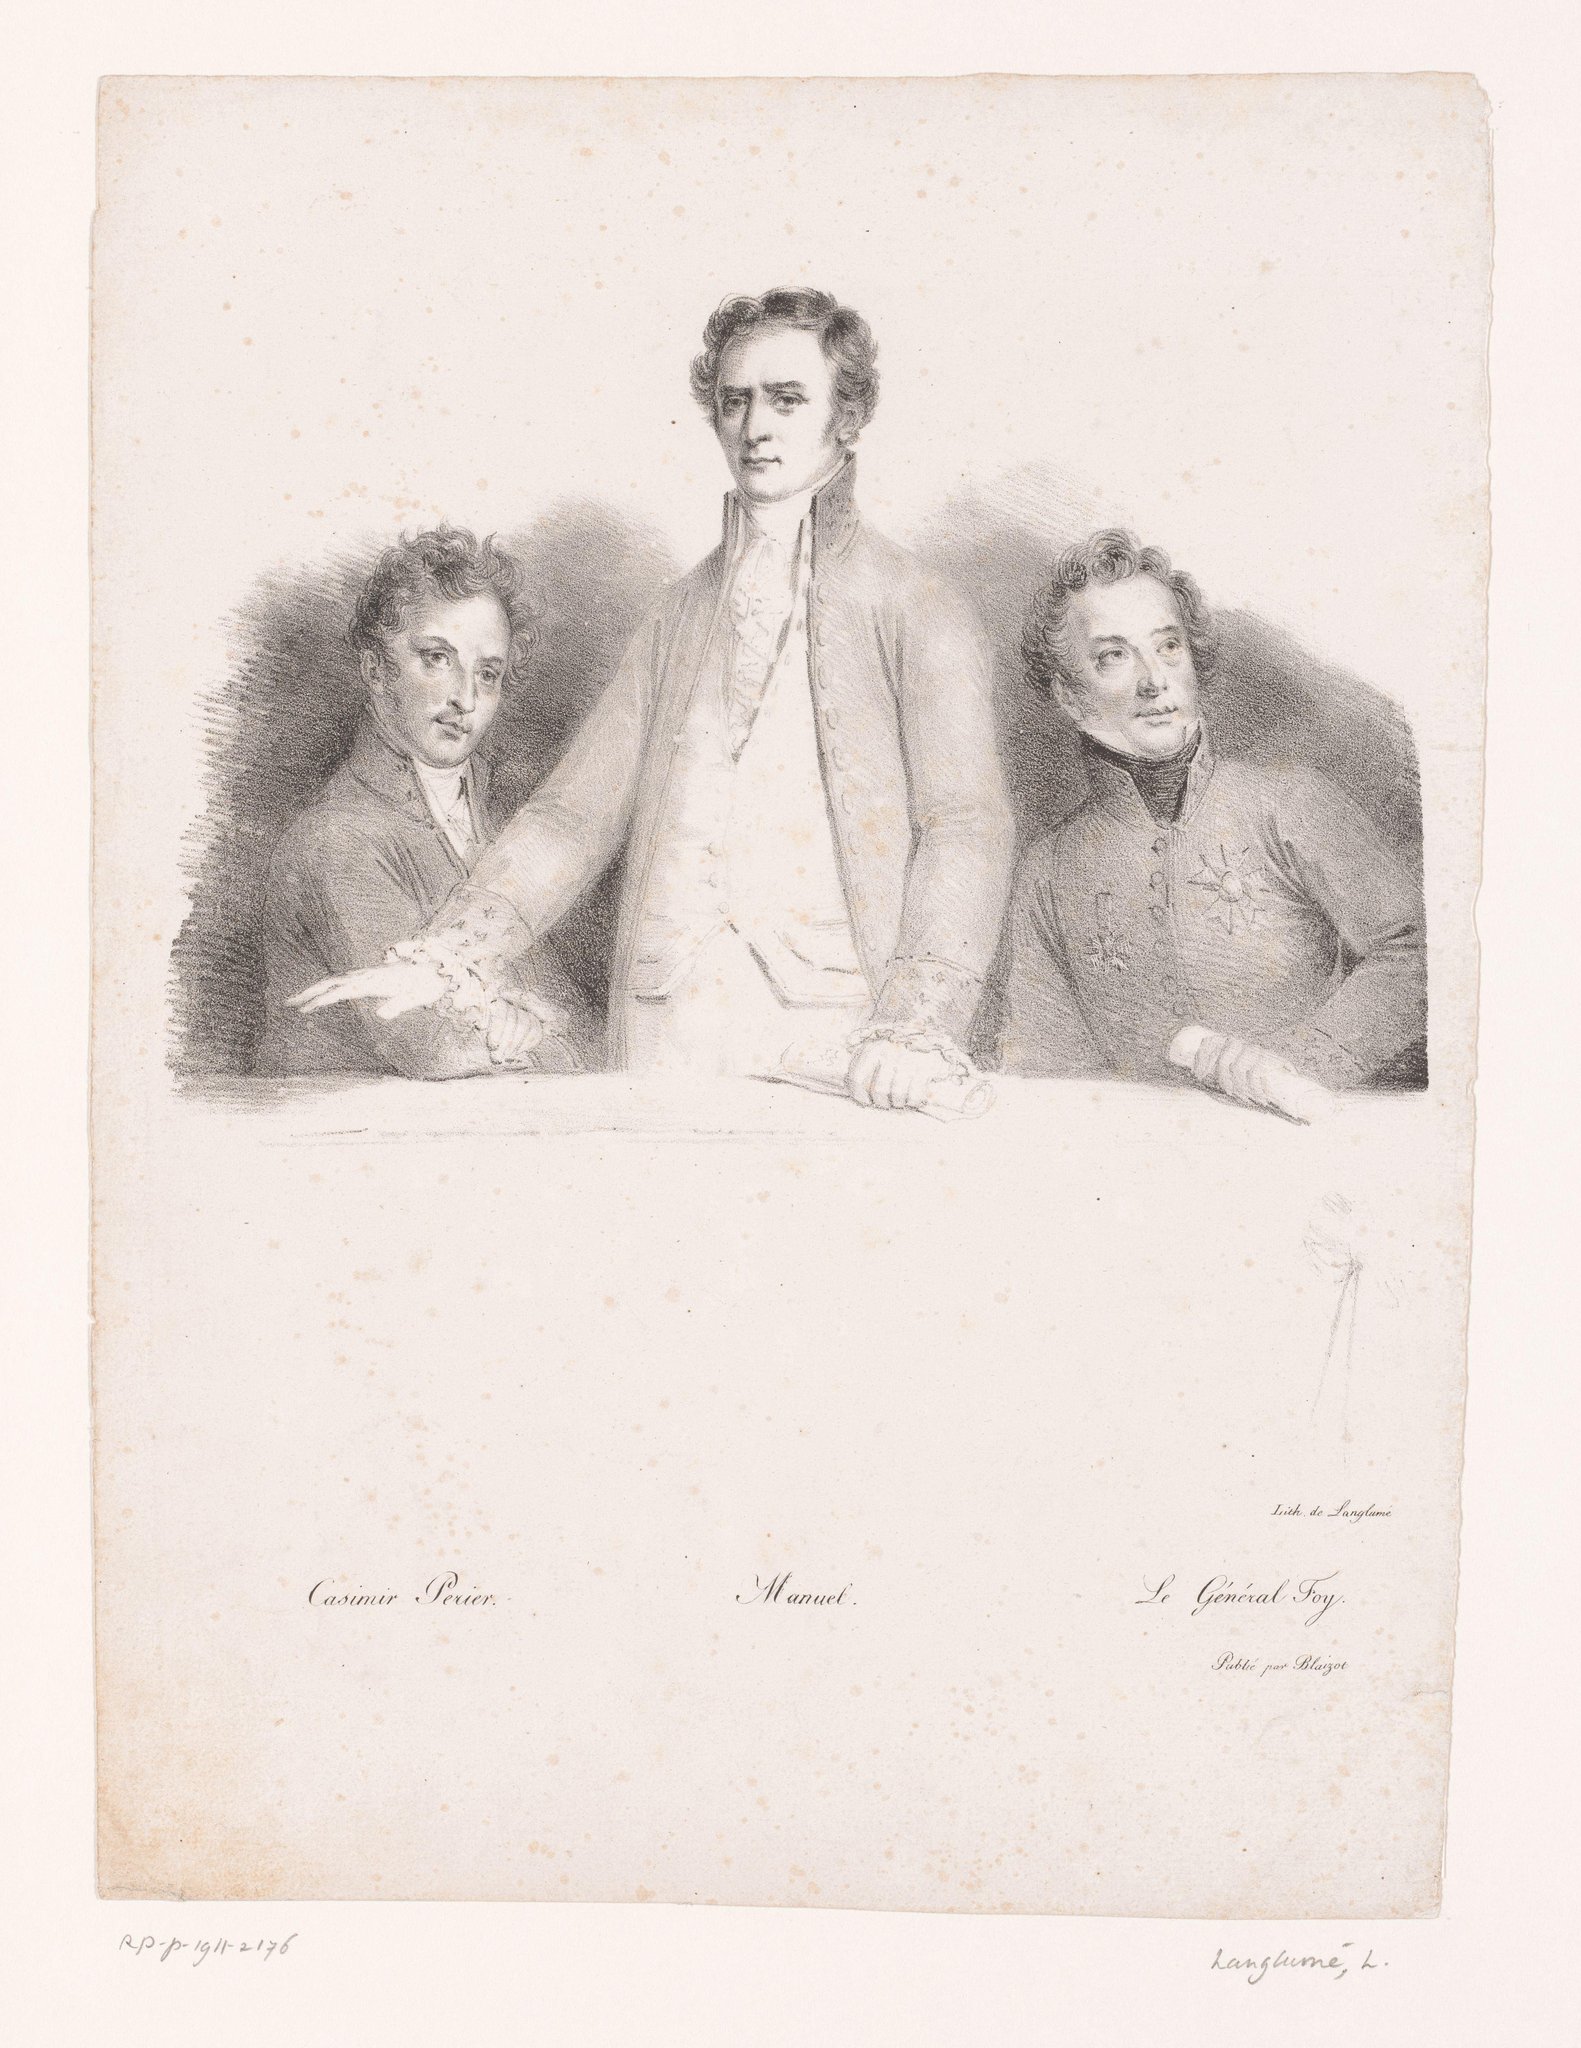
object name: print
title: Portret van Casimir-Pierre Perier, Jacques-Antoine Manuel en Maximilien Sébastien Foy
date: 1823-1830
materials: paper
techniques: lithograph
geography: paris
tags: maximilien sébastien foy, paris, politician, historical persons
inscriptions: collector's mark: Lugt 2228a